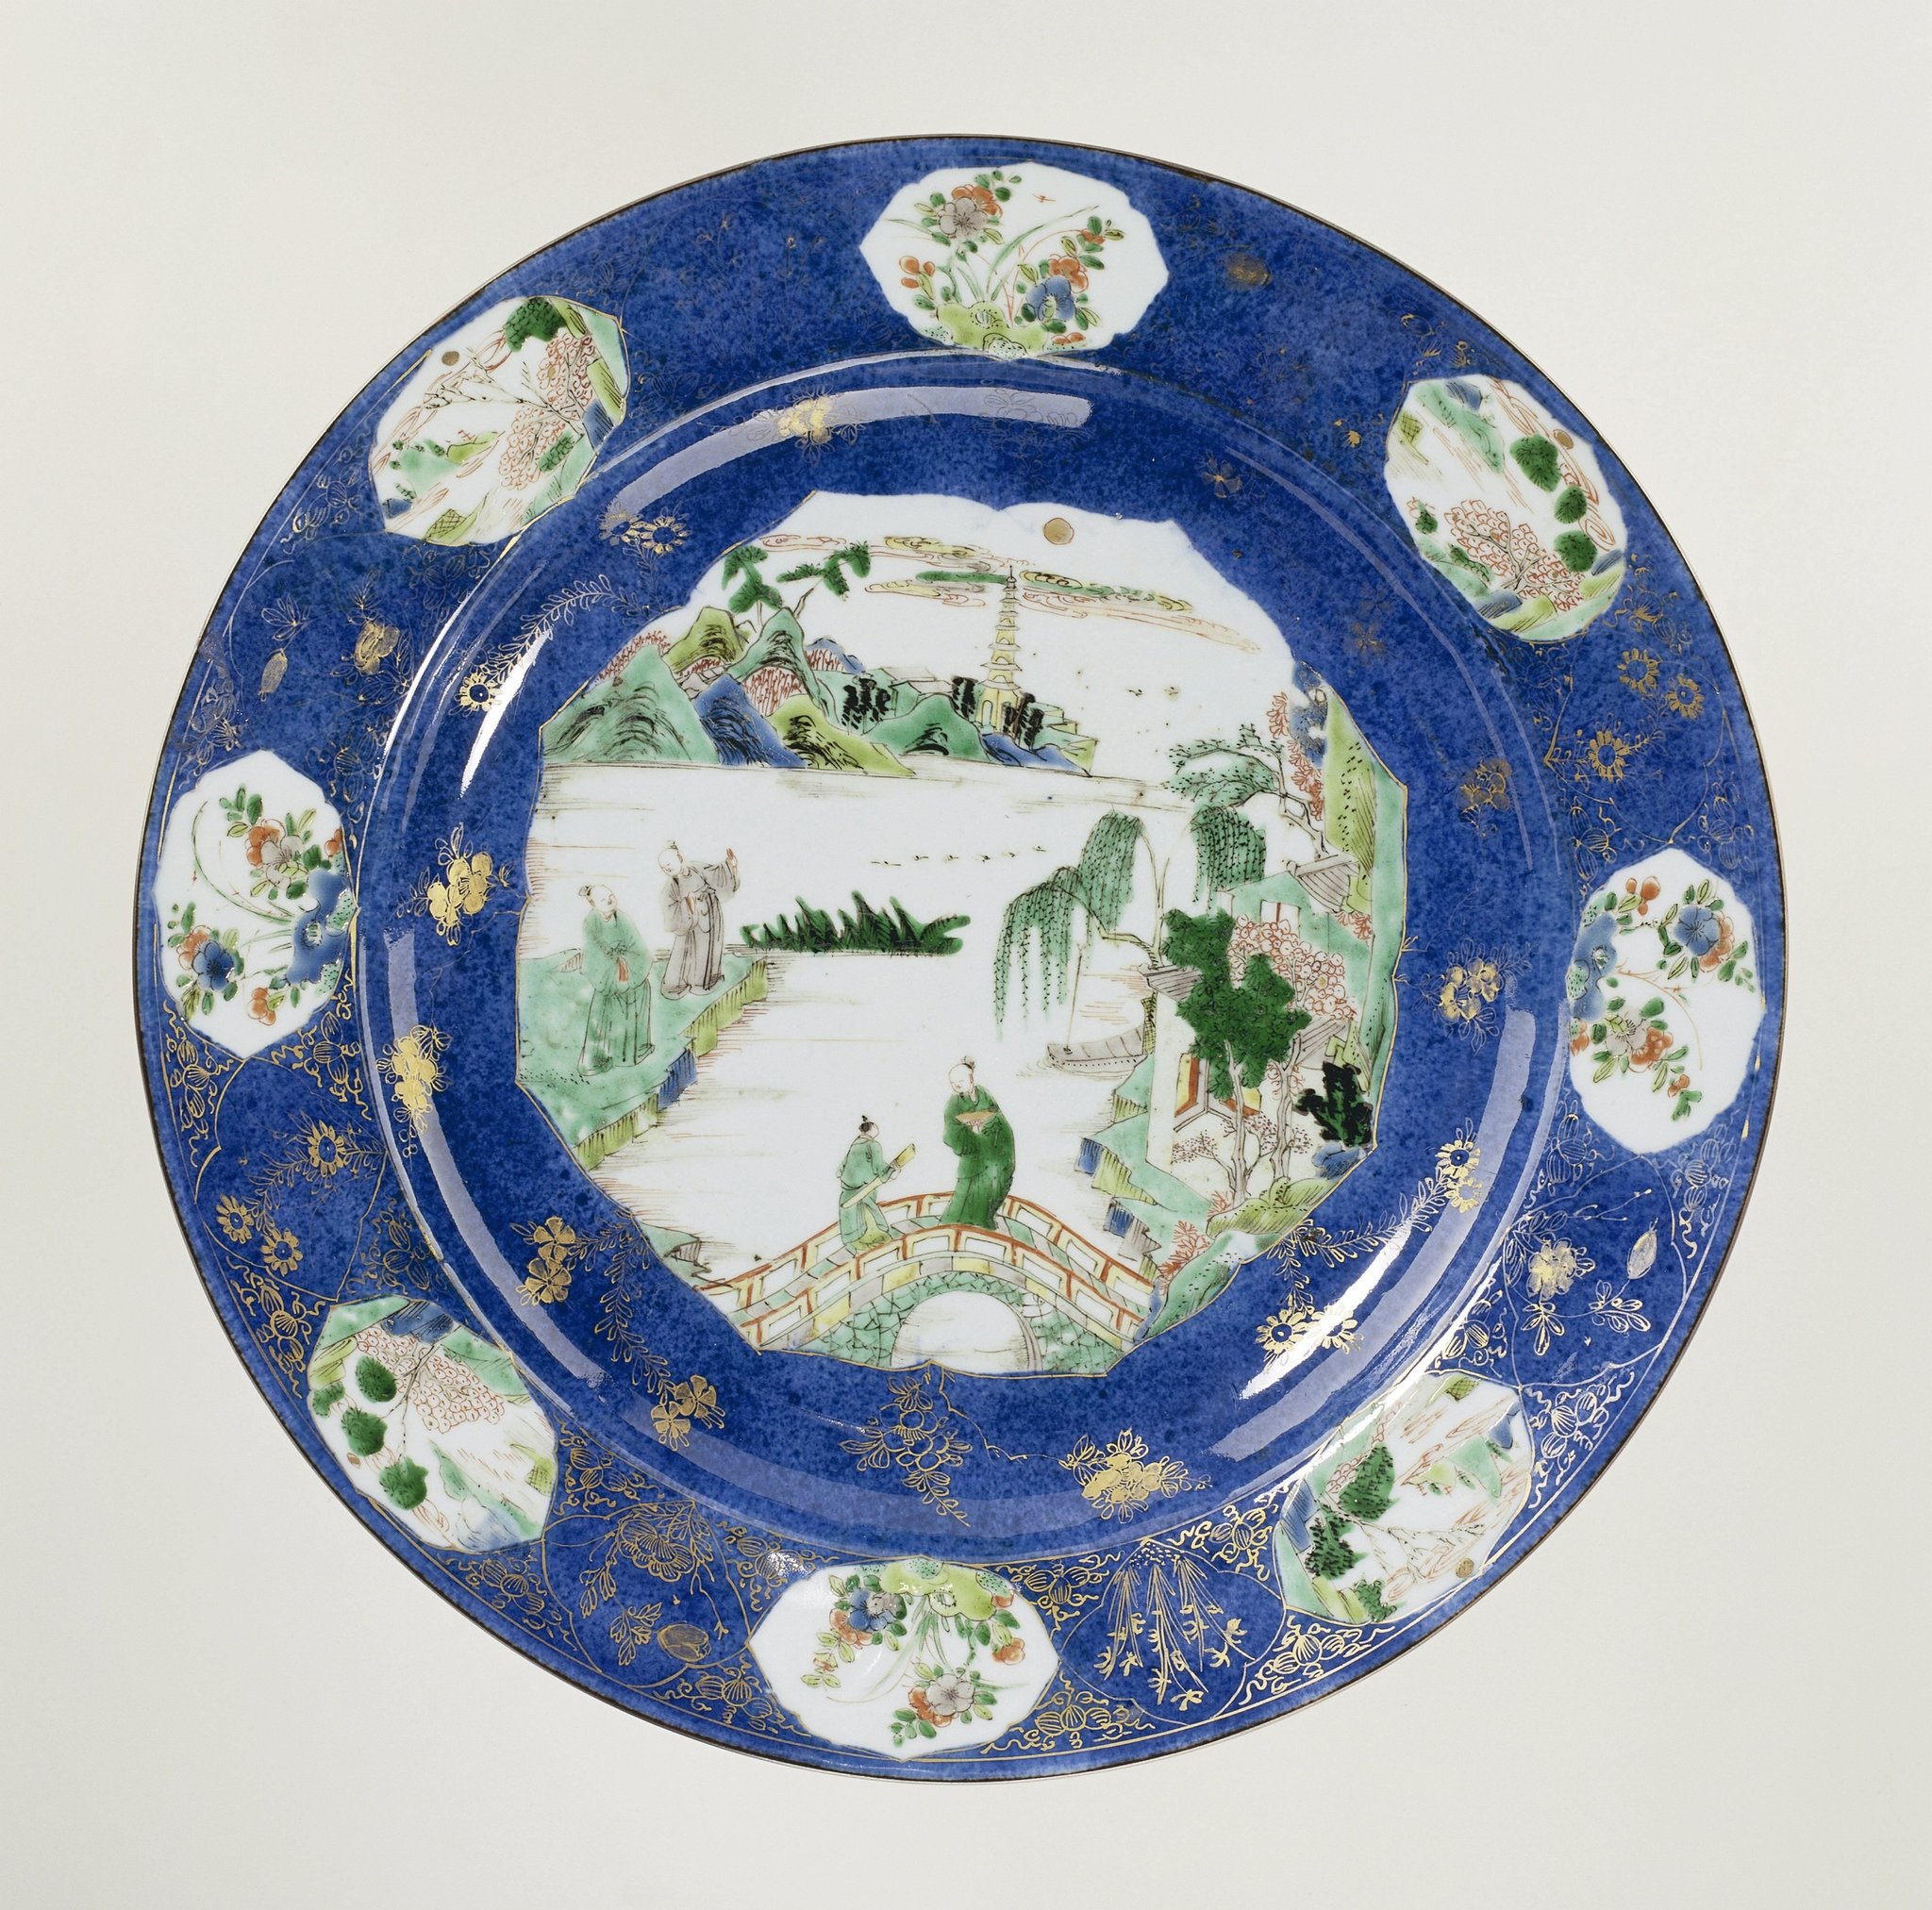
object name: platter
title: Dish with powder blue and panels in reserve with river landscapes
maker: Anonymous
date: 1700-1720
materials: cobalt, glaze, gold, paint, porcelain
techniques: firing, gilding, turning, vitrification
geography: china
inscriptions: mark